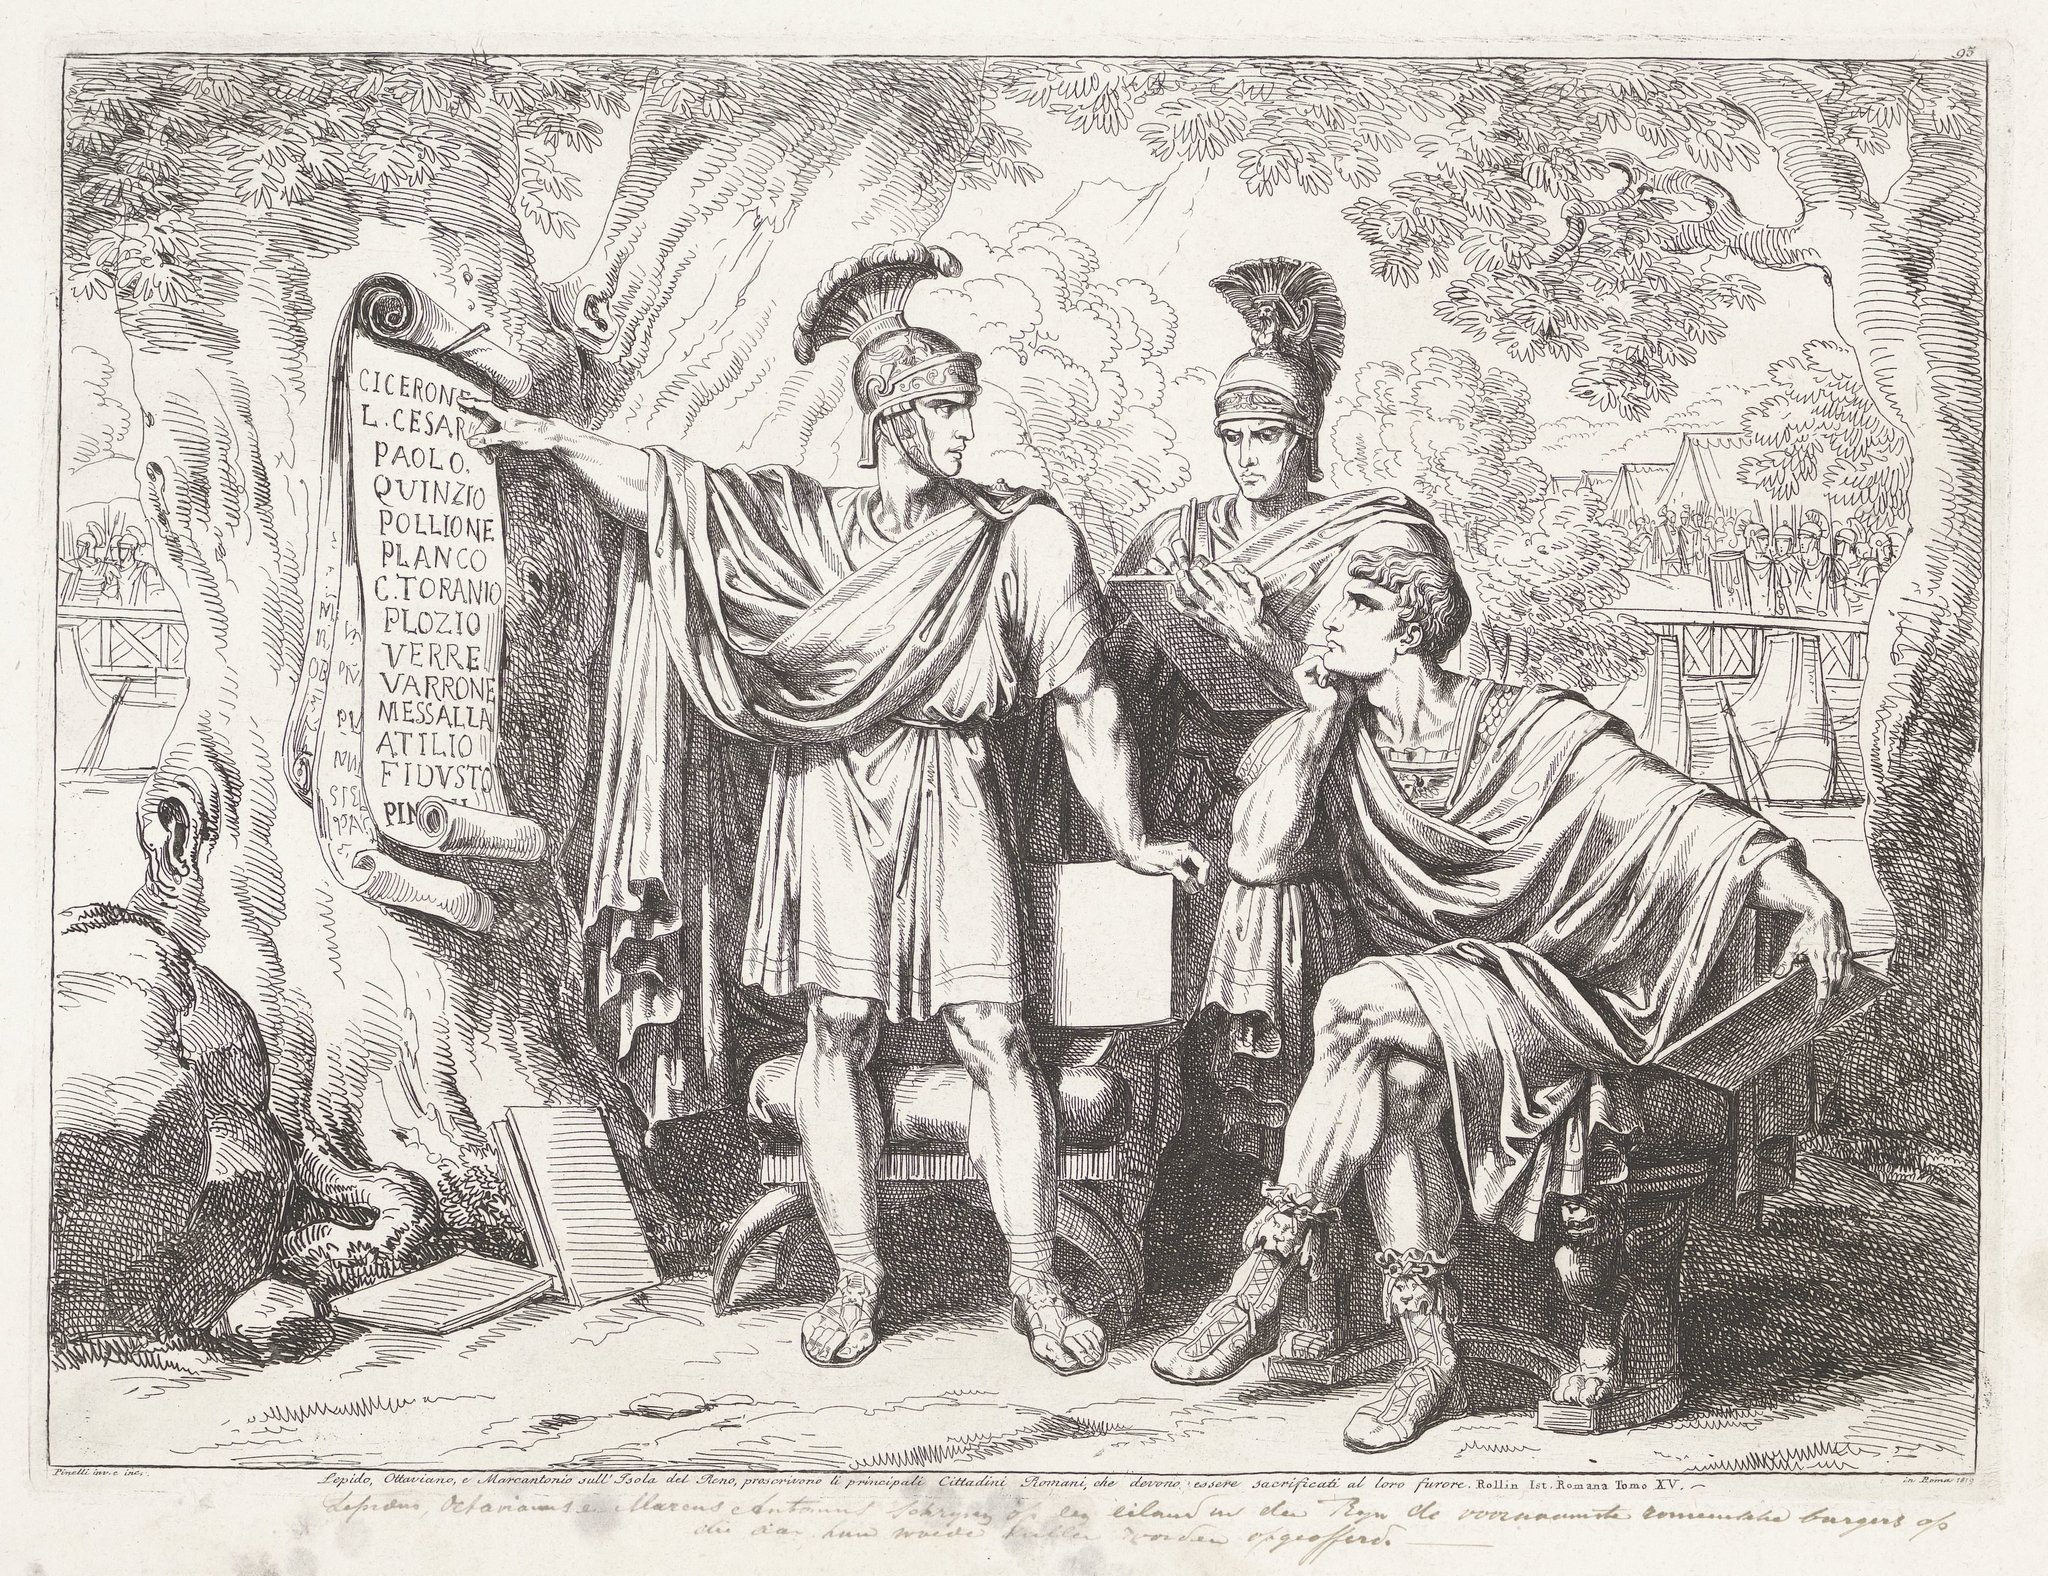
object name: print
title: Lepidus, Octavianus en Marcus Antonius maken een lijst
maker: bartolomeo pinelli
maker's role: draughtsman, print maker, sculptor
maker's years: 1781-1835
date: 1818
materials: paper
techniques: etching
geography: rome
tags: (story of) mark antony, (story of) marcus aemilius lepidus, (story of) augustus, the roman emperor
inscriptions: inscription: ‘Lepidus, Octavianus en Marcus Antonius schrijven op een eiland in den Reyn de voornaamste Romeinsche burgers op / die aan hun wode zullen worden opgeofferd.’, collector's mark: Lugt 2228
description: Lepidus, Octavianus en Marcus Antonius maken een lijst met namen van de voornaamste Romeinen, die ze ongestraft mogen executeren en hun bezit mogen onteigenen (het tweede triumviraat). Op de achtergrond een legerkamp.